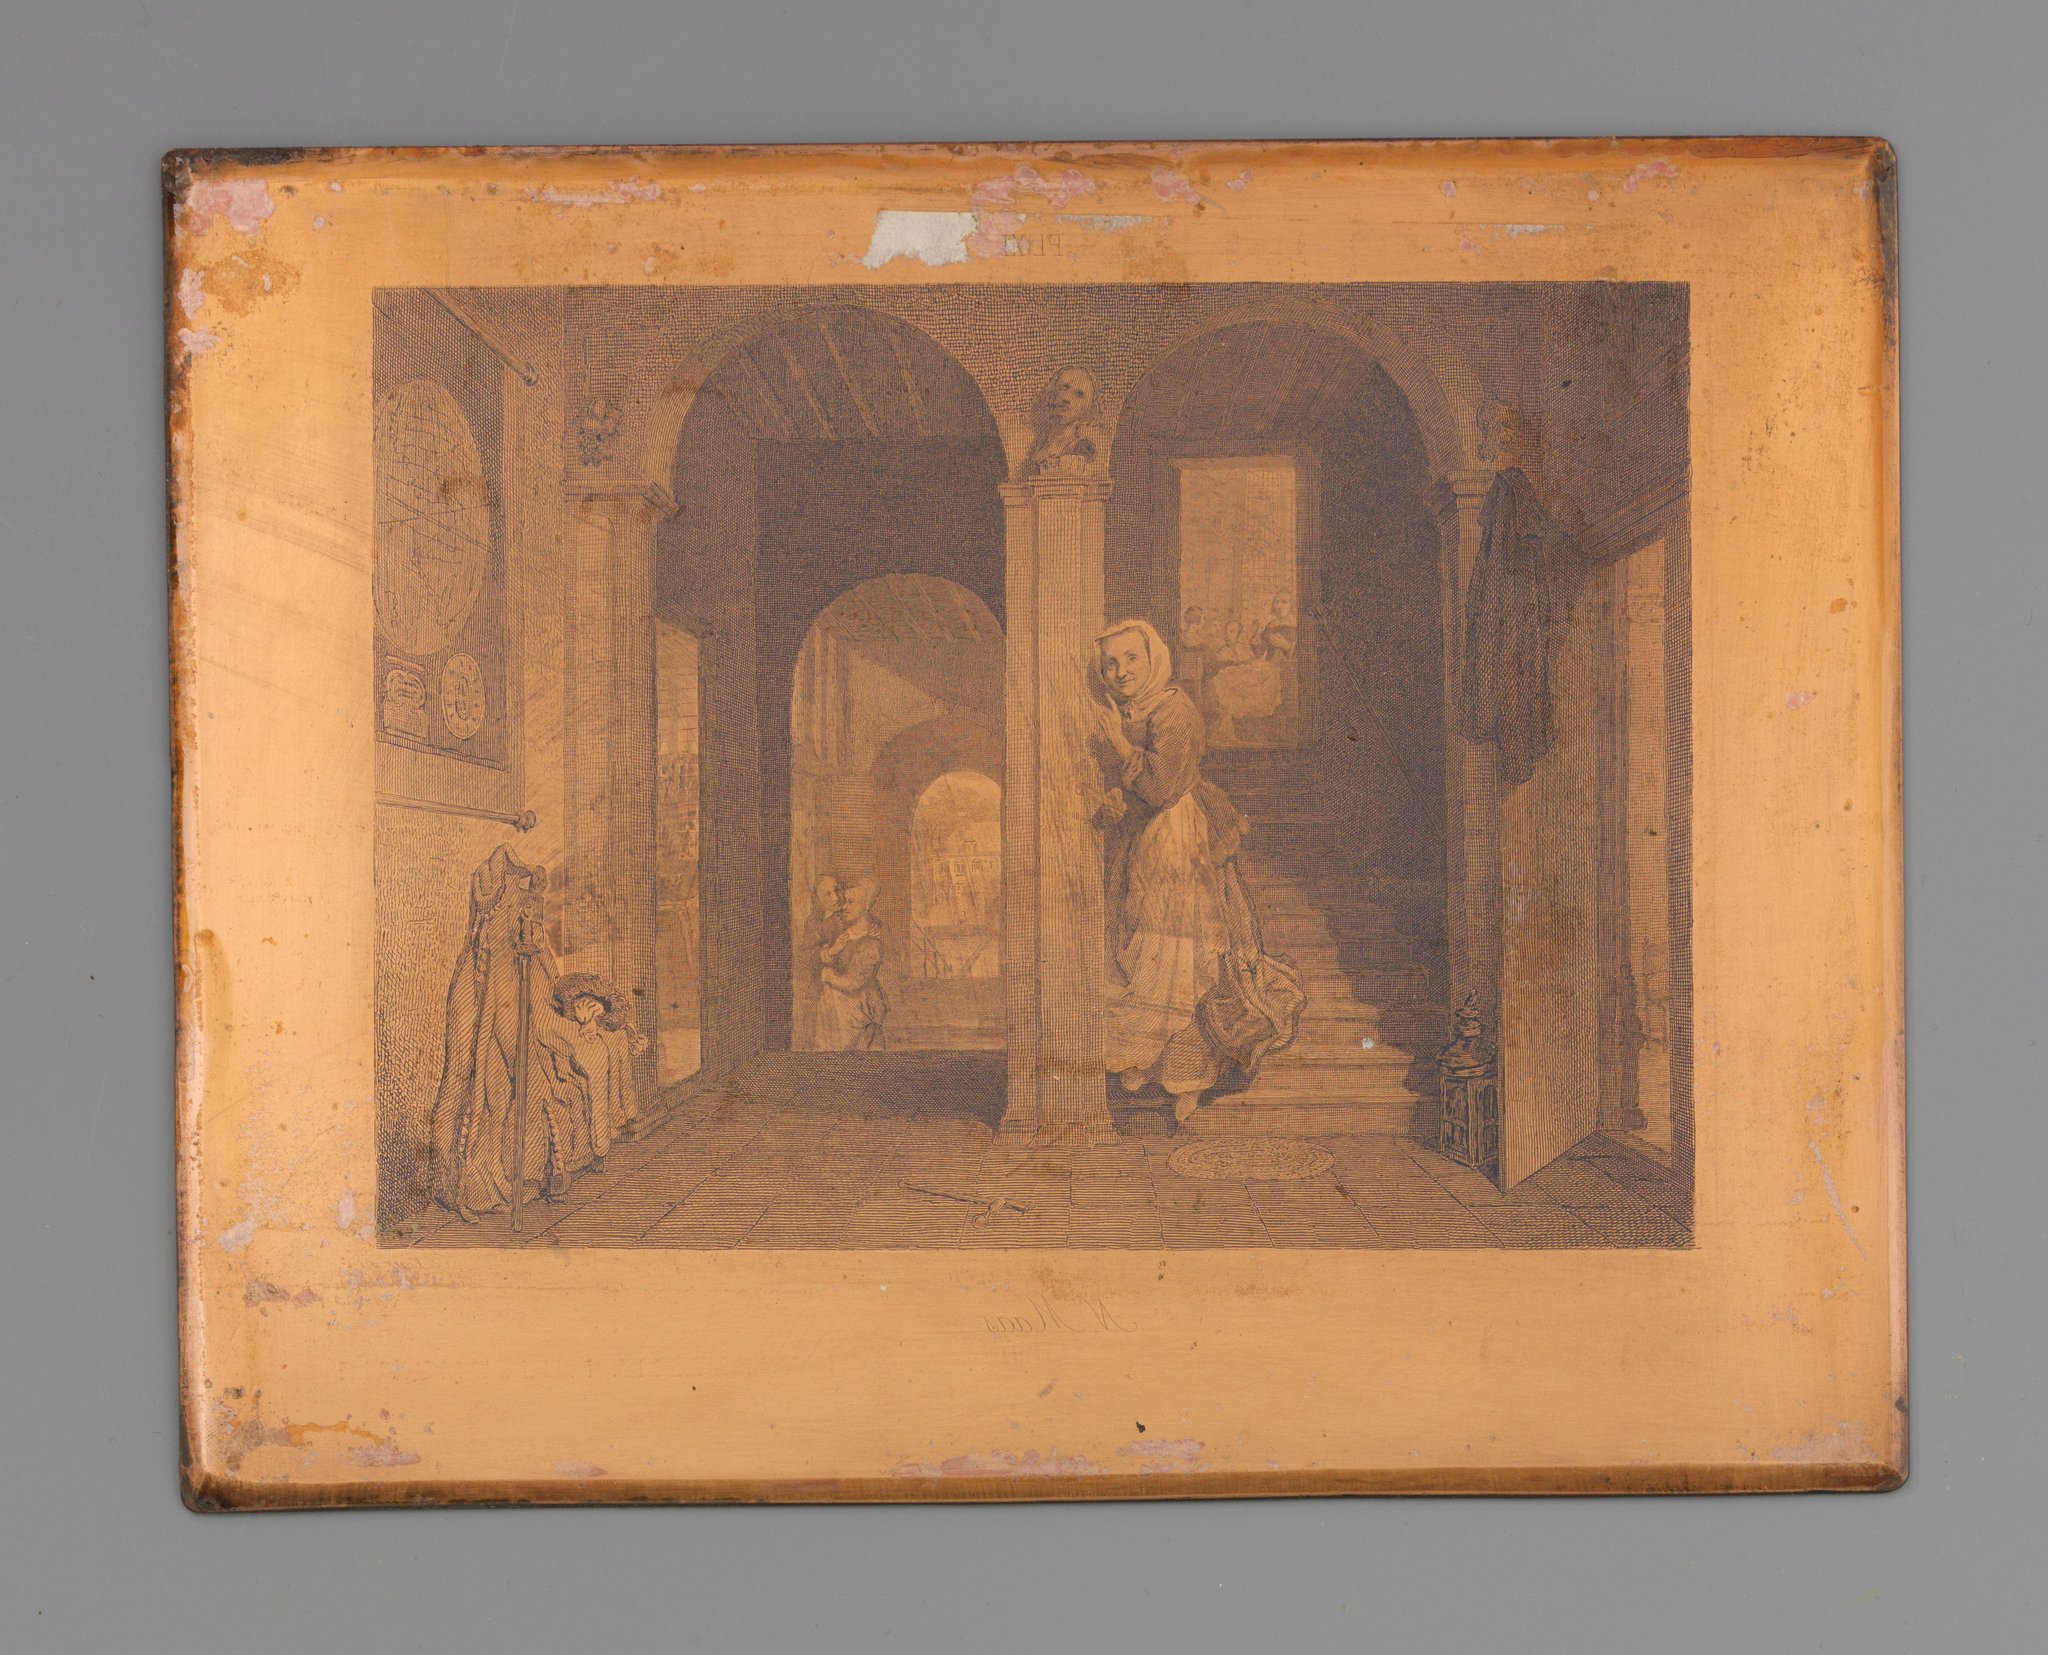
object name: copper plate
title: De luistervink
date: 1823-1900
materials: copper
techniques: etching